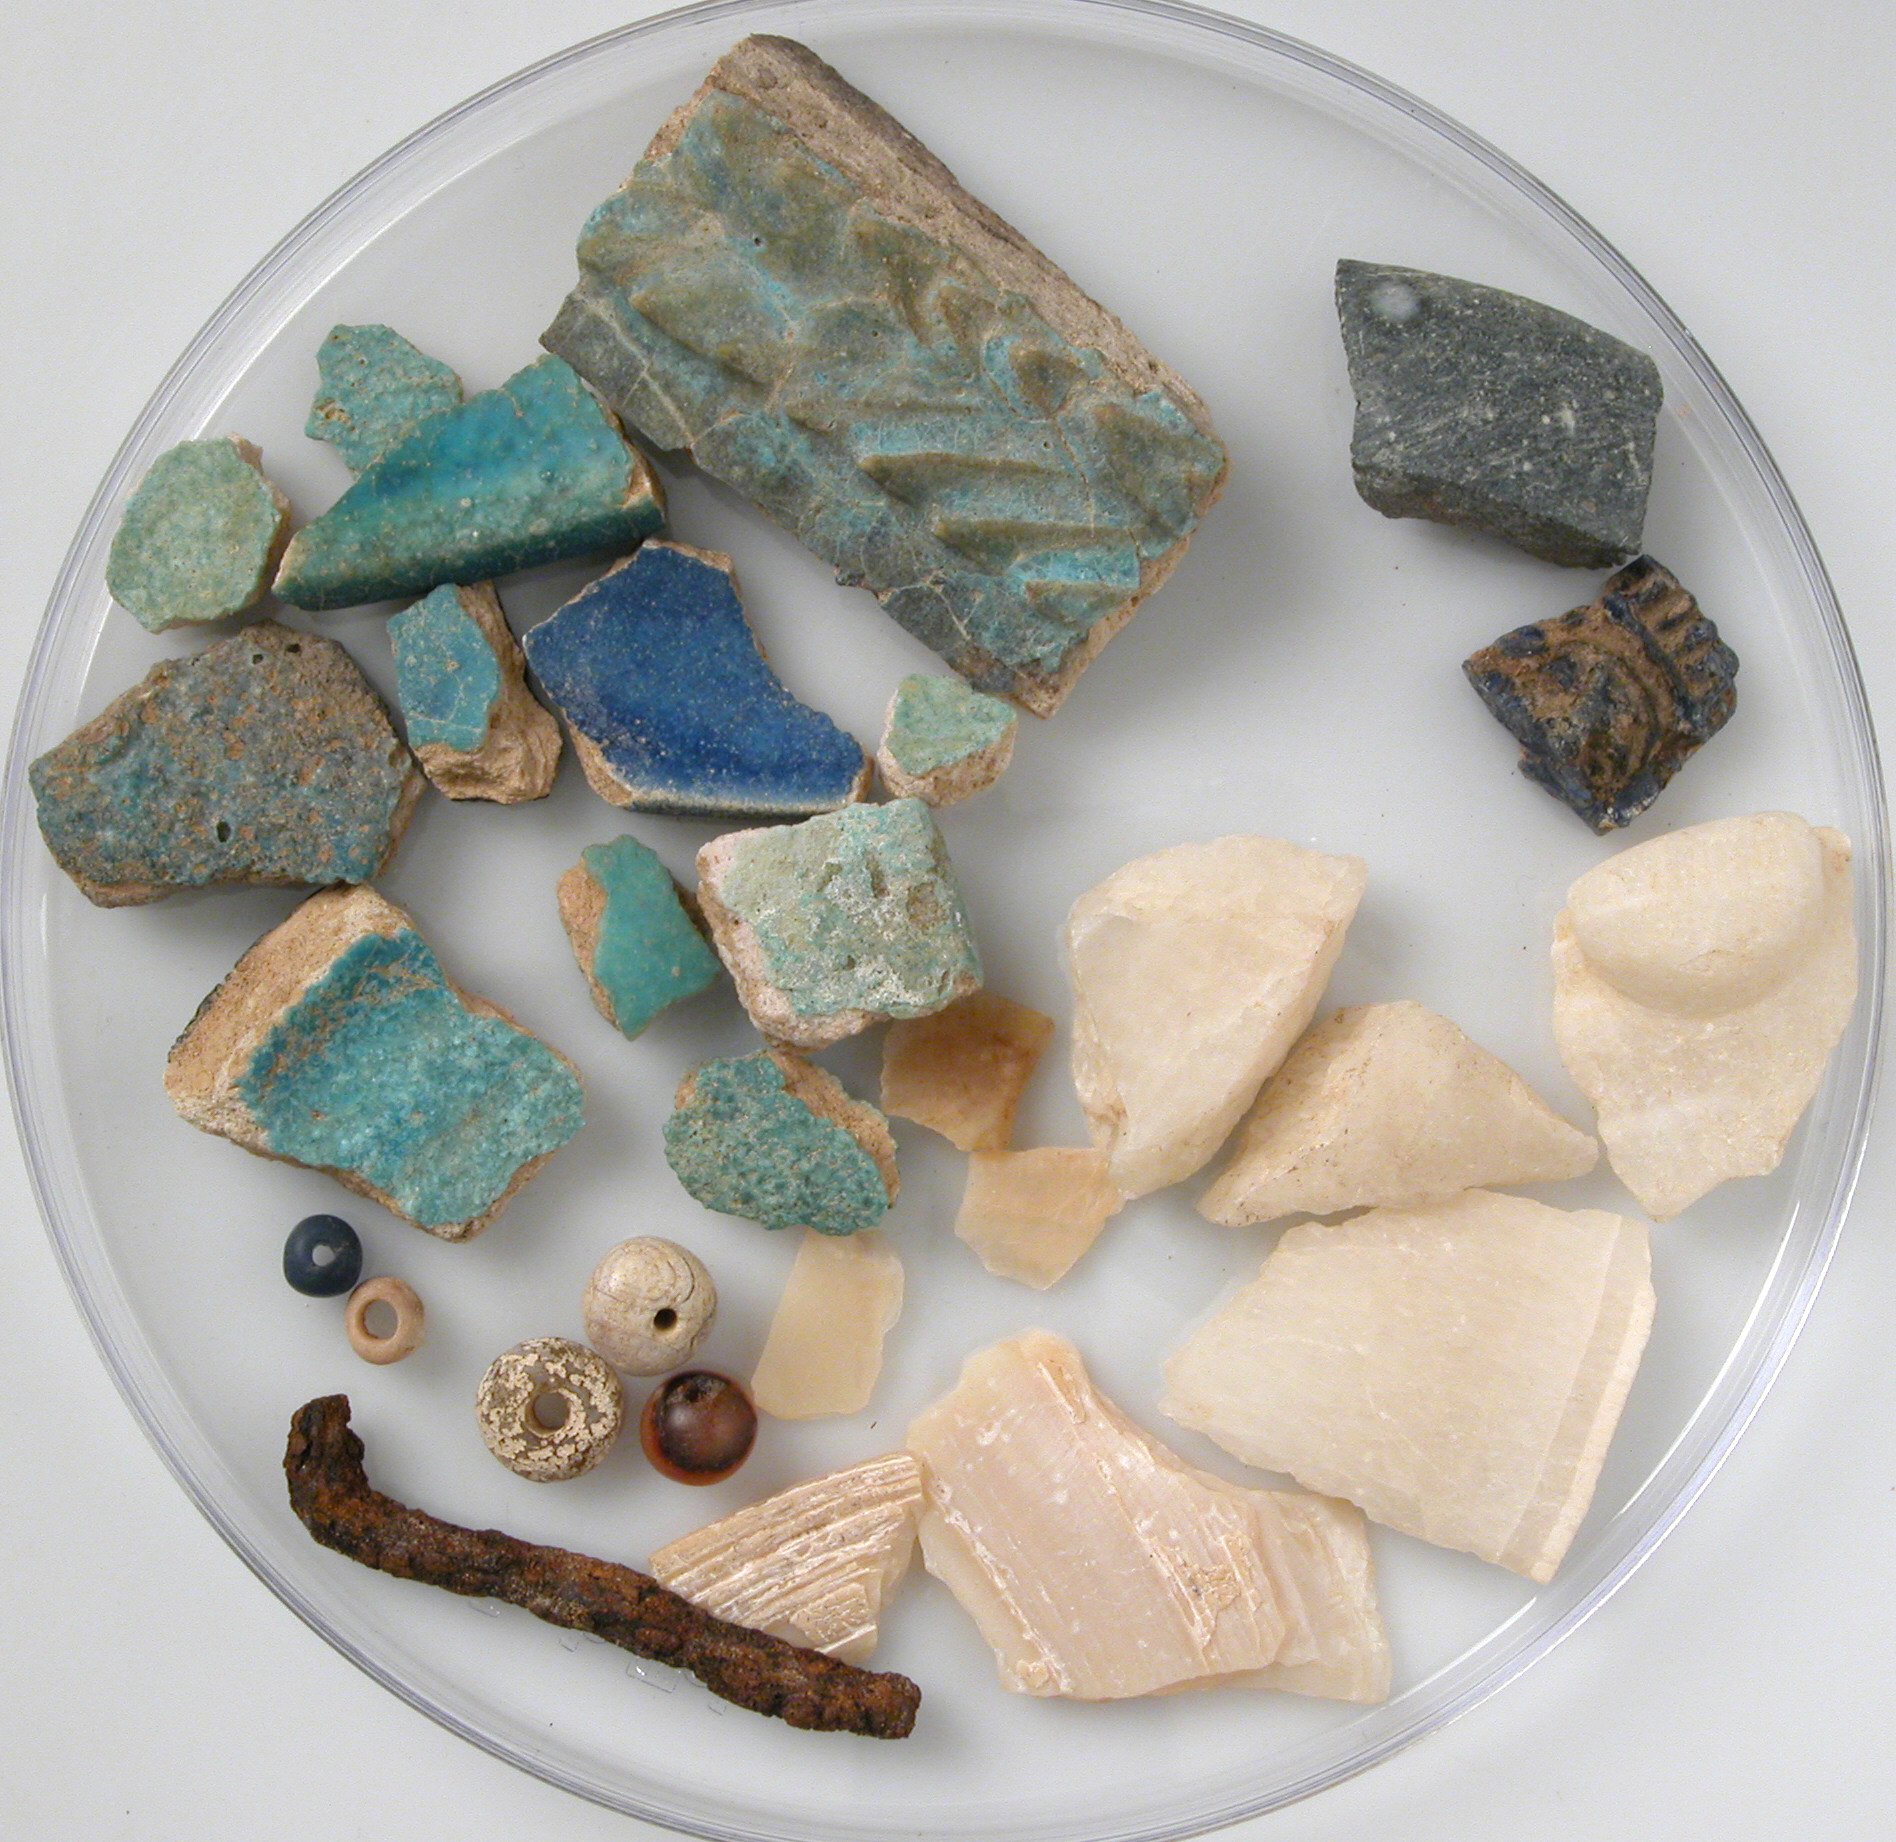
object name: fragment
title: Fragments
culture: coptic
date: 301-700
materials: earthenware, glass, metal, shell, stone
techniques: glazing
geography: egypt